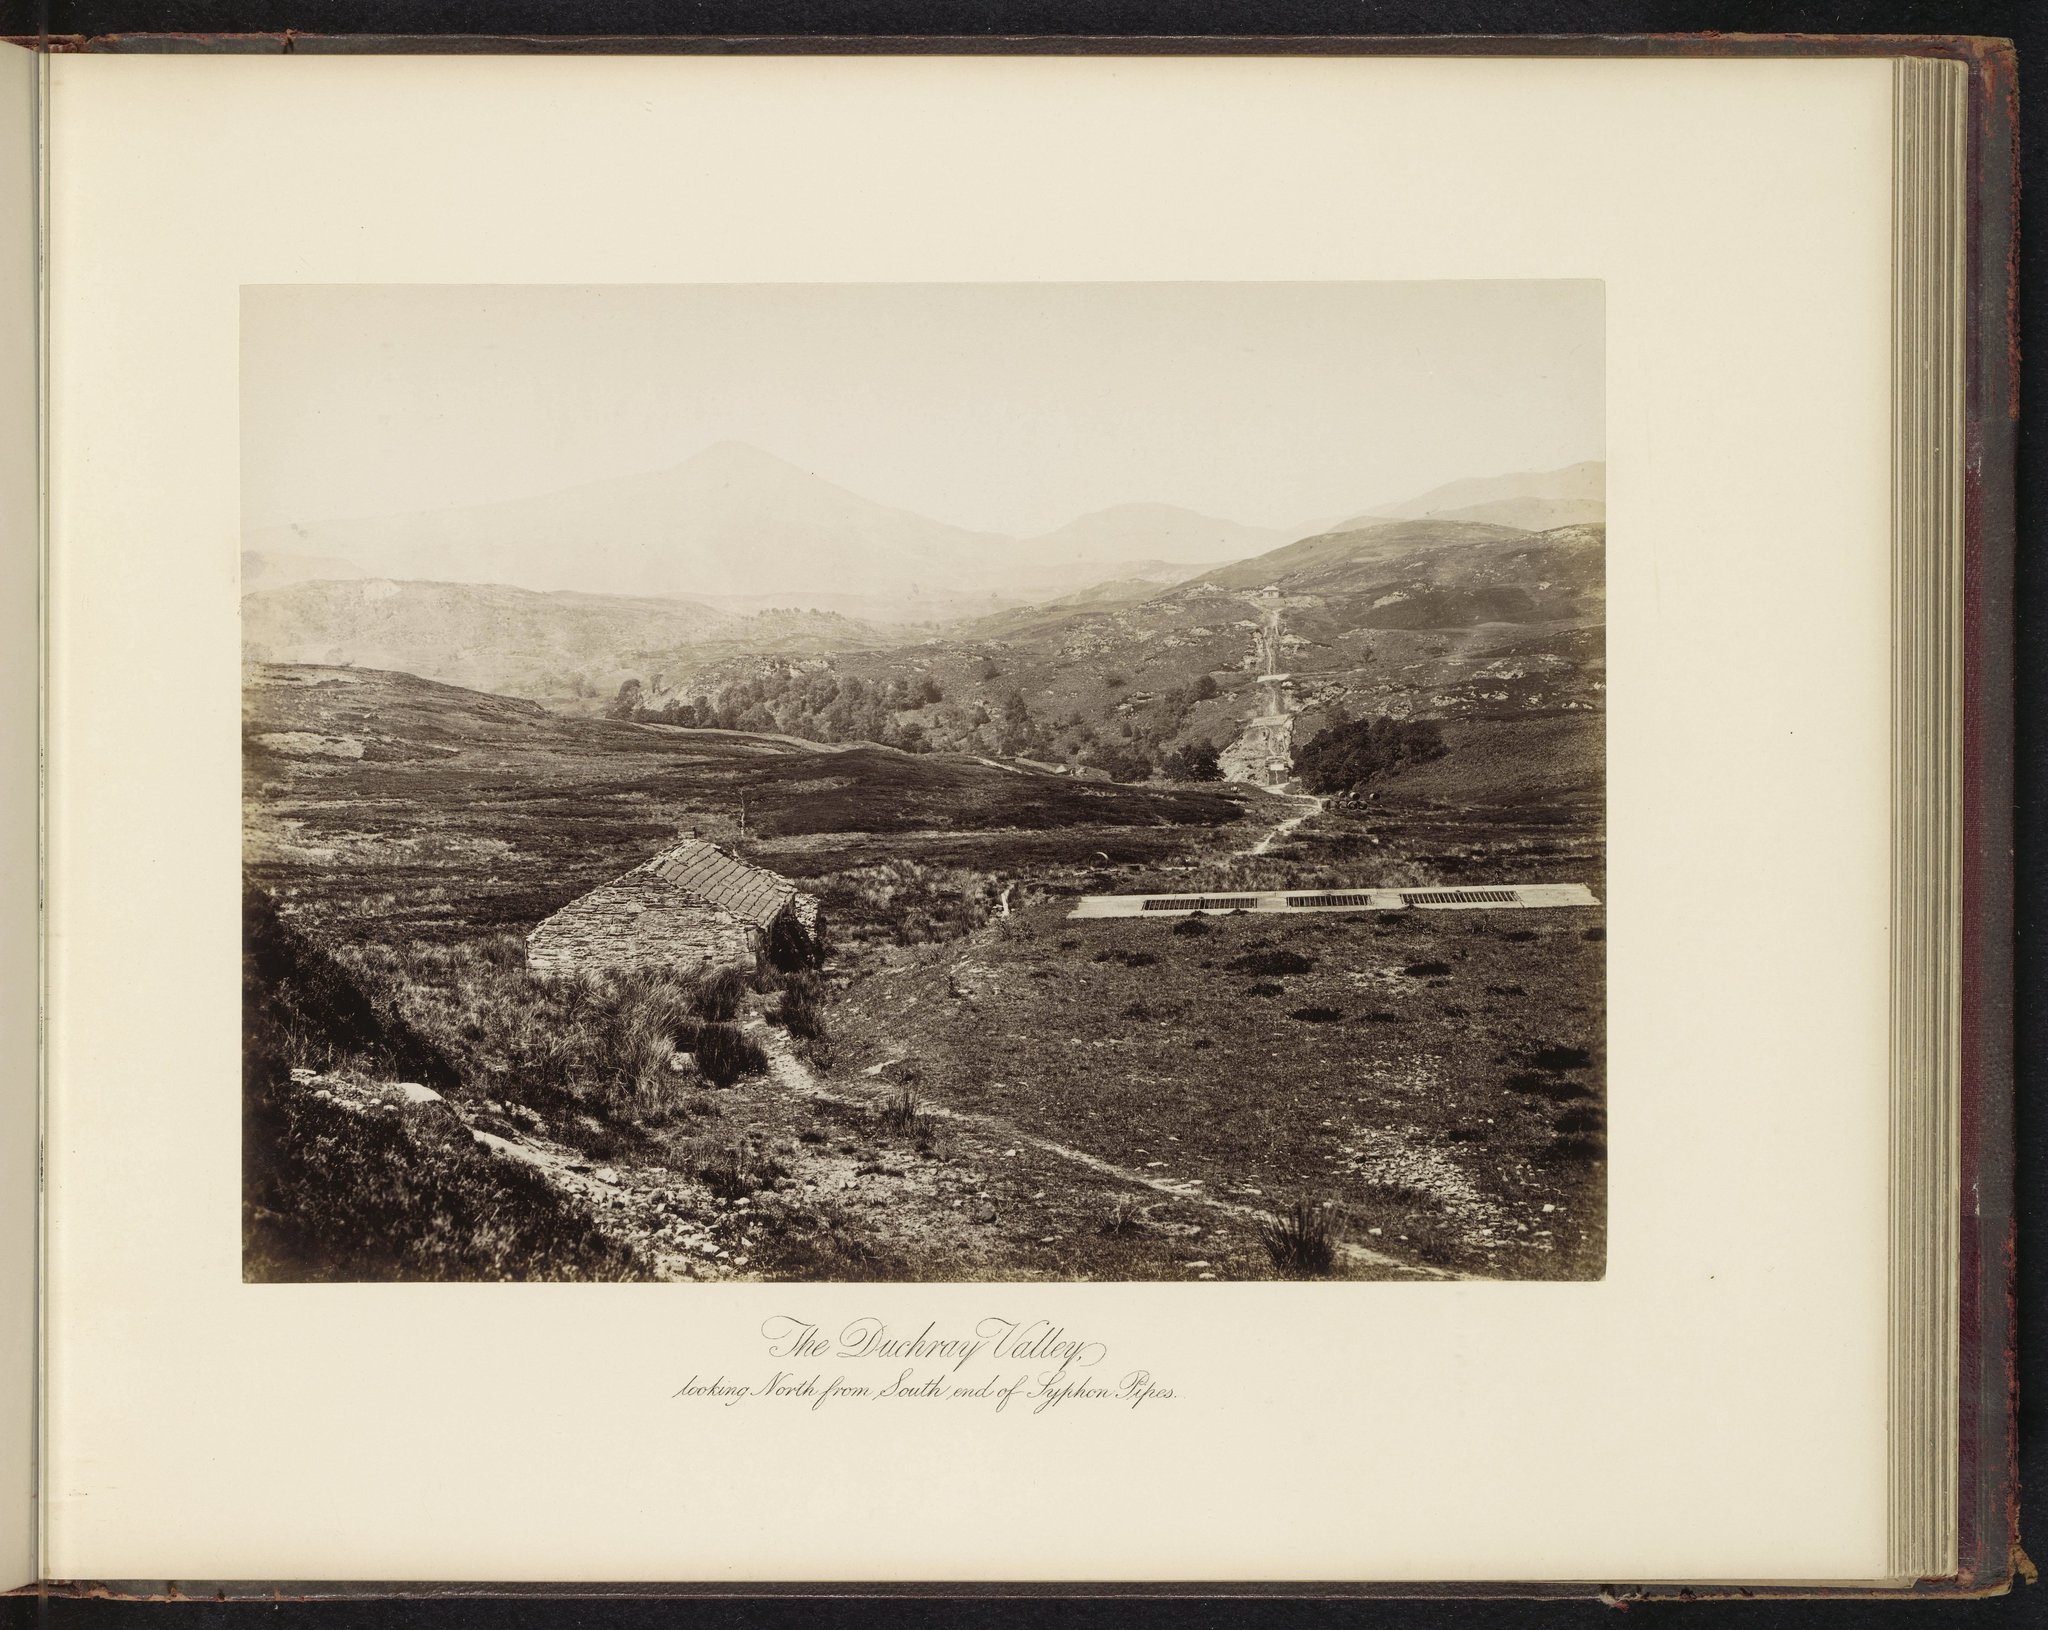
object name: page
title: The Duchray Valley, looking North from South end of syphon pipes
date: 1879-1889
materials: photographic support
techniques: albumen print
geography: stirling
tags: dale, valley